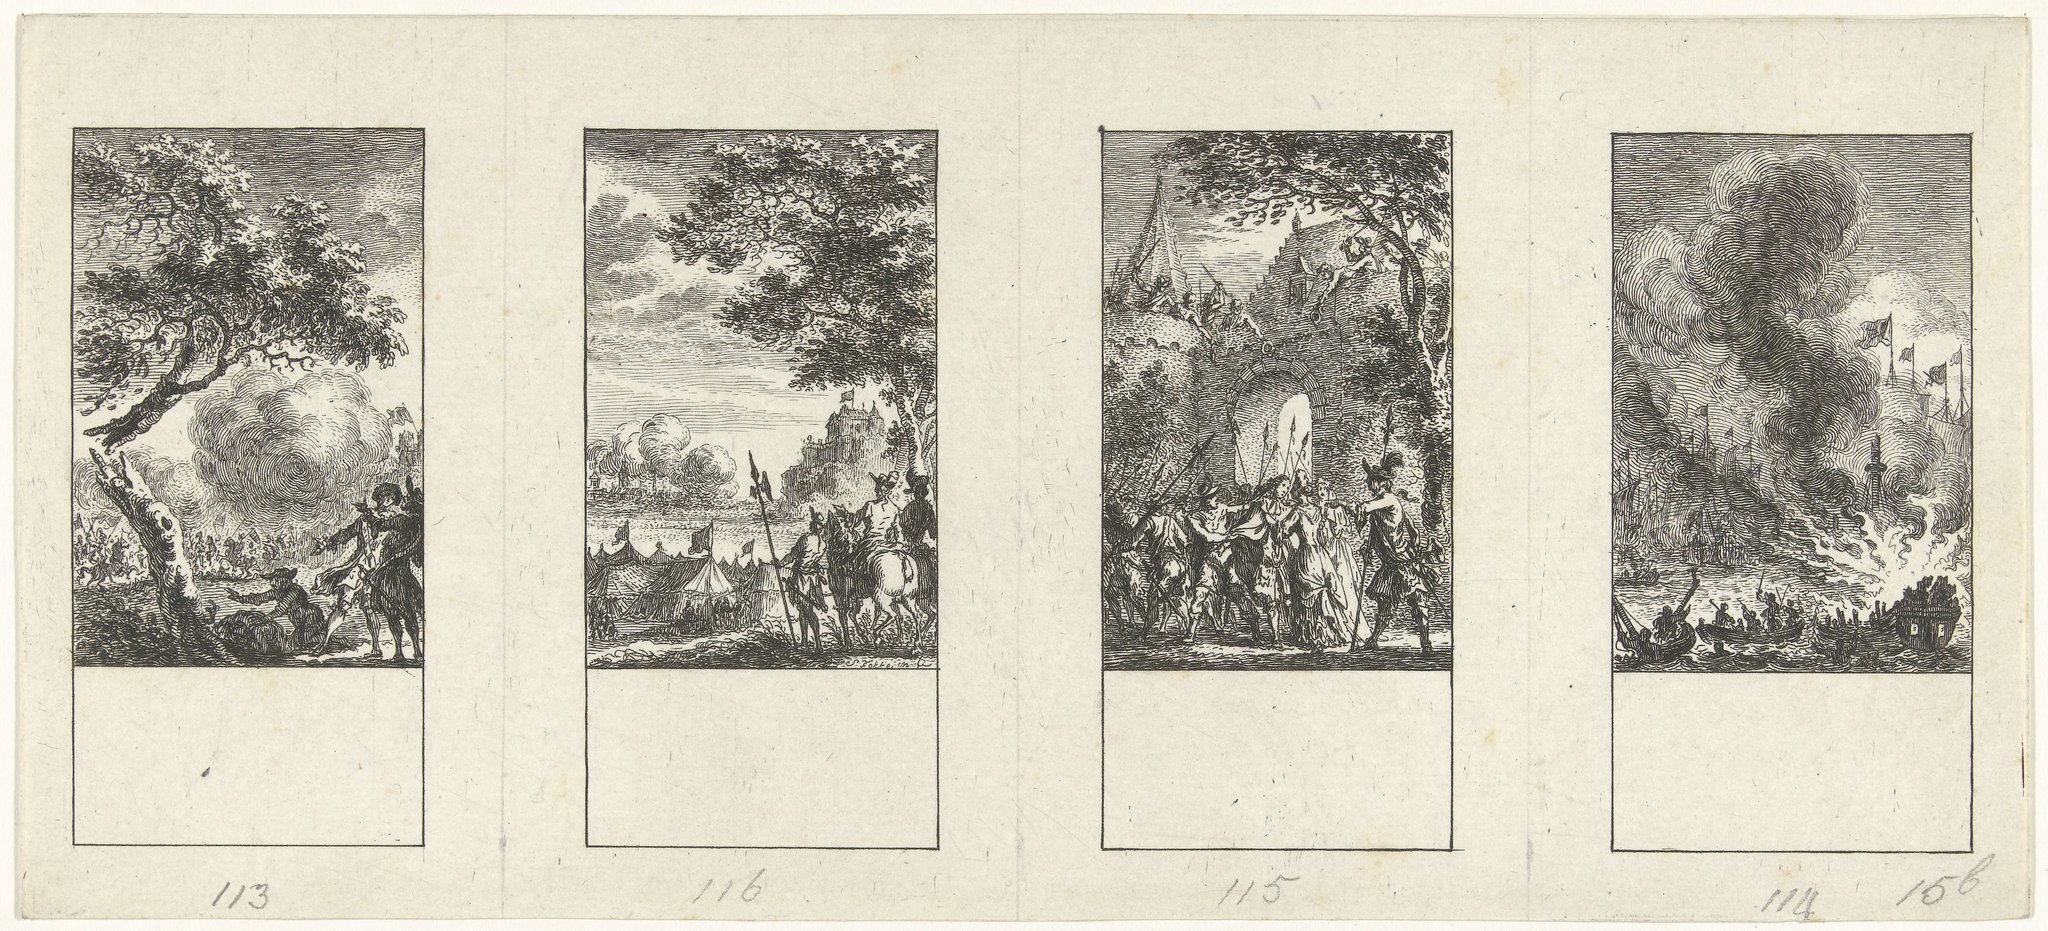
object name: print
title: Illustraties vaderlandse geschiedenis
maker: simon fokke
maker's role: draughtsman, print maker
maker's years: 1712-1784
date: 1722-1784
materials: paper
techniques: etching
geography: amsterdam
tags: jacobus ii (koning van engeland en schotland), the hague, william iii (prince of orange and king of england, scotland, and ireland), mayor, historical events and situations, historical persons (portraits and scenes from the life)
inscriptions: collector's mark: Lugt 2228, number: ‘113, 116, 115, 114’